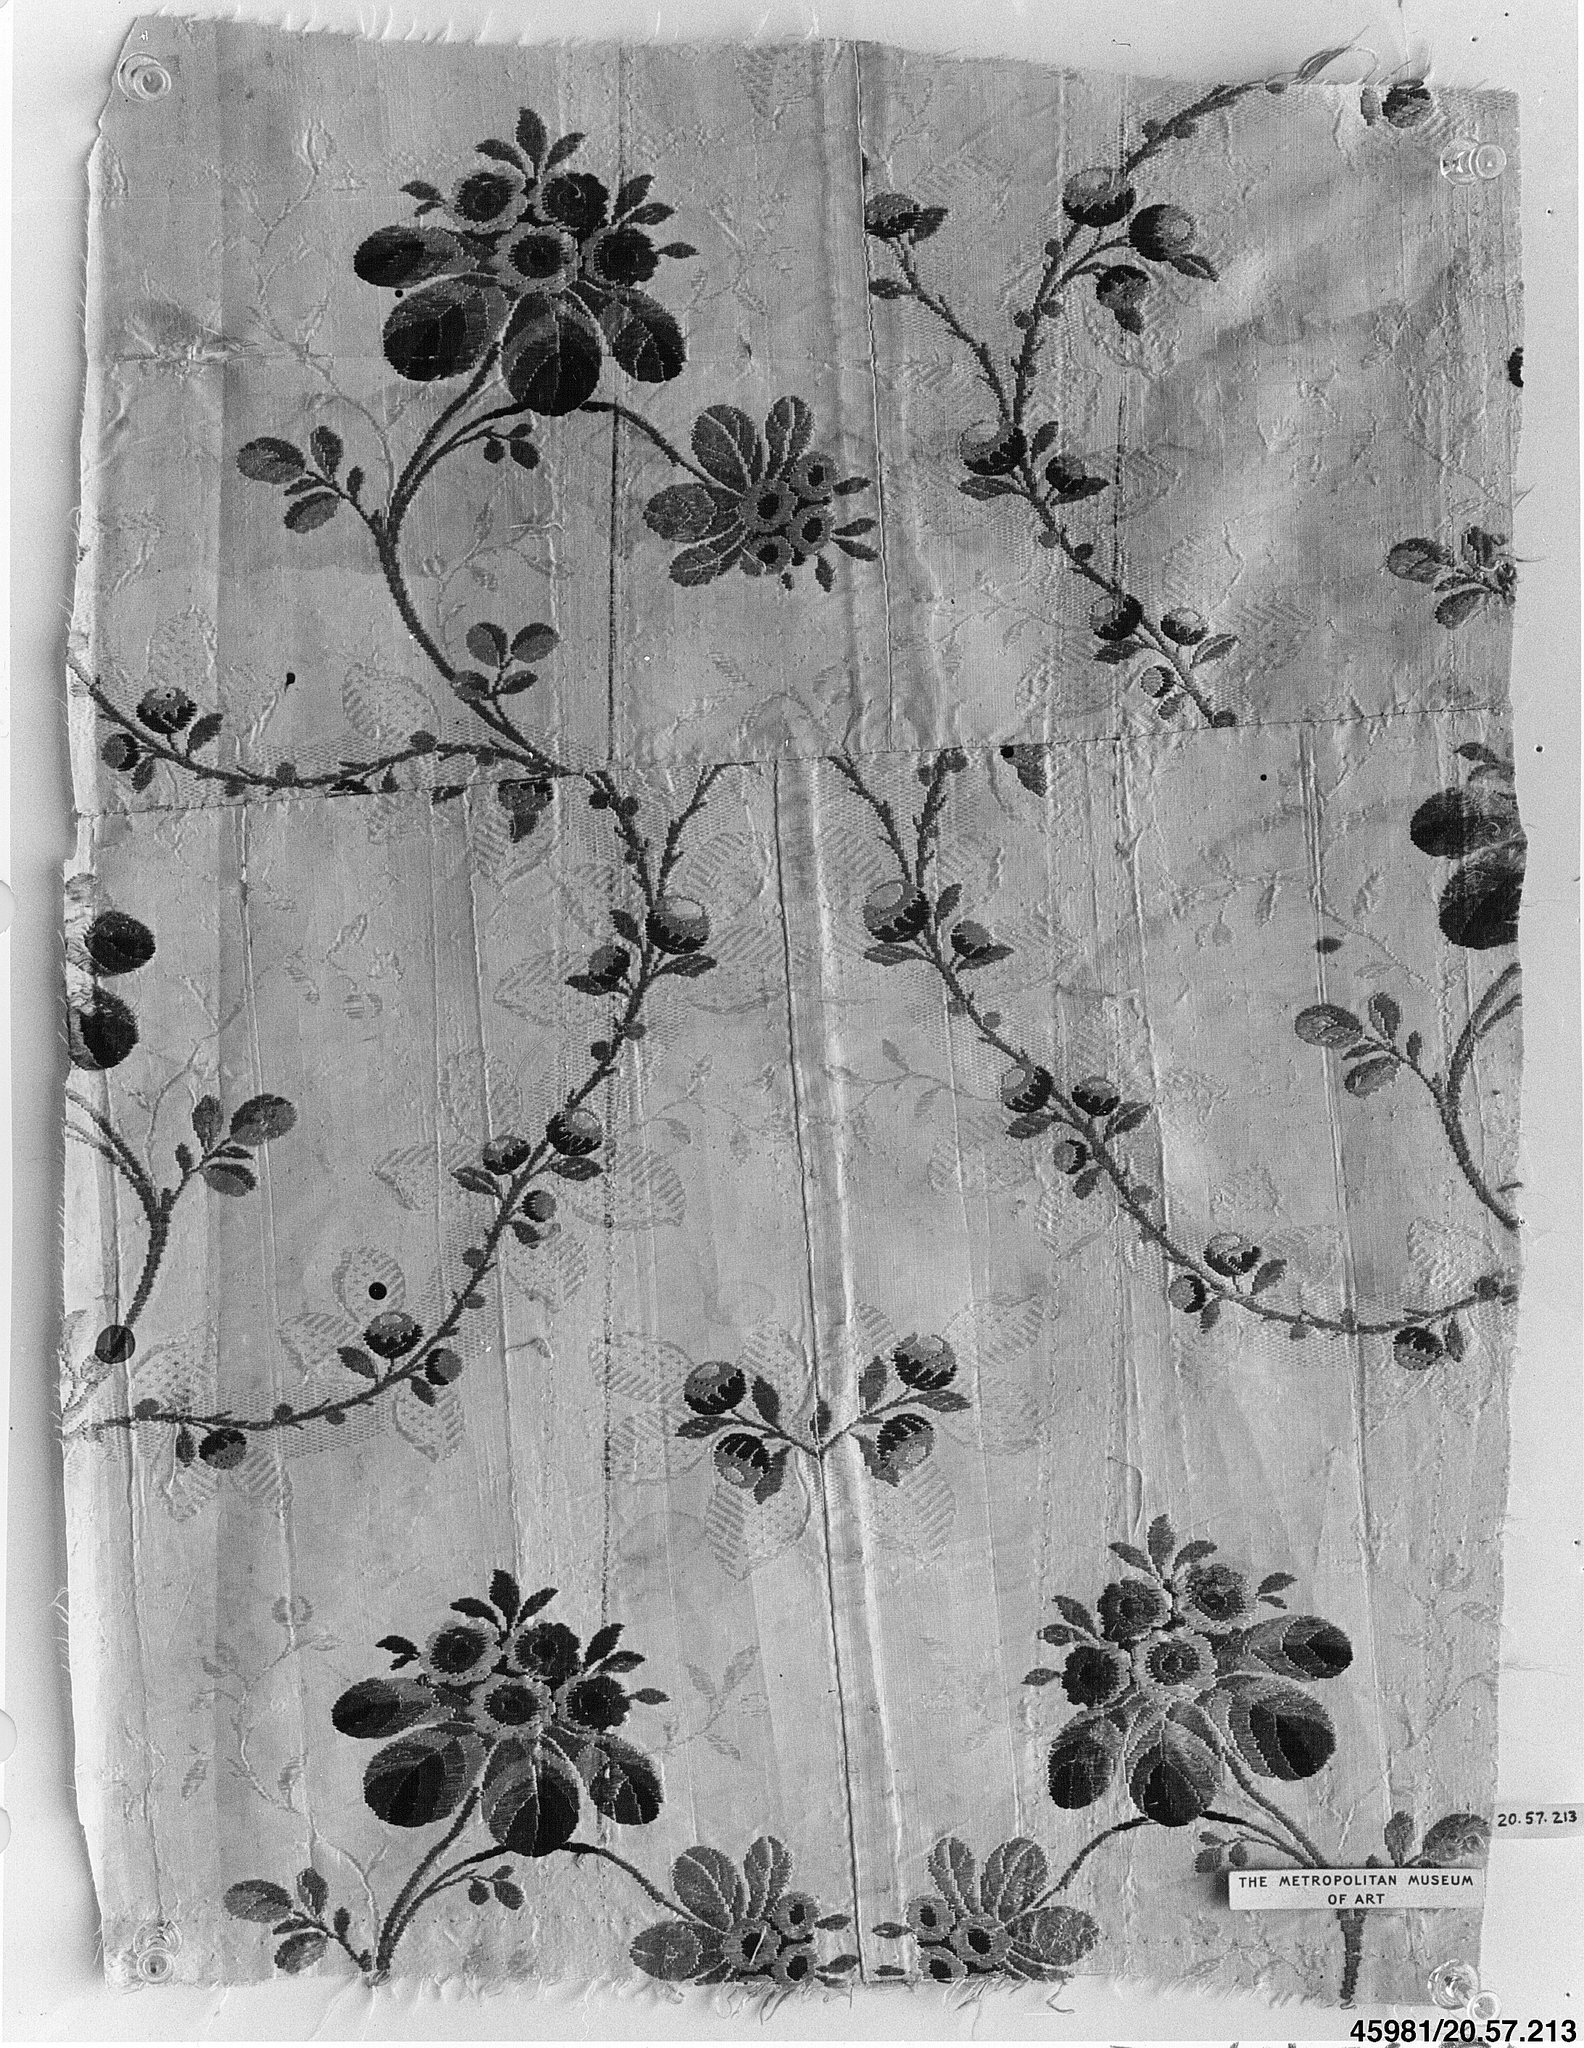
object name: piece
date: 1750-1760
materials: silk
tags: flowers,leaves